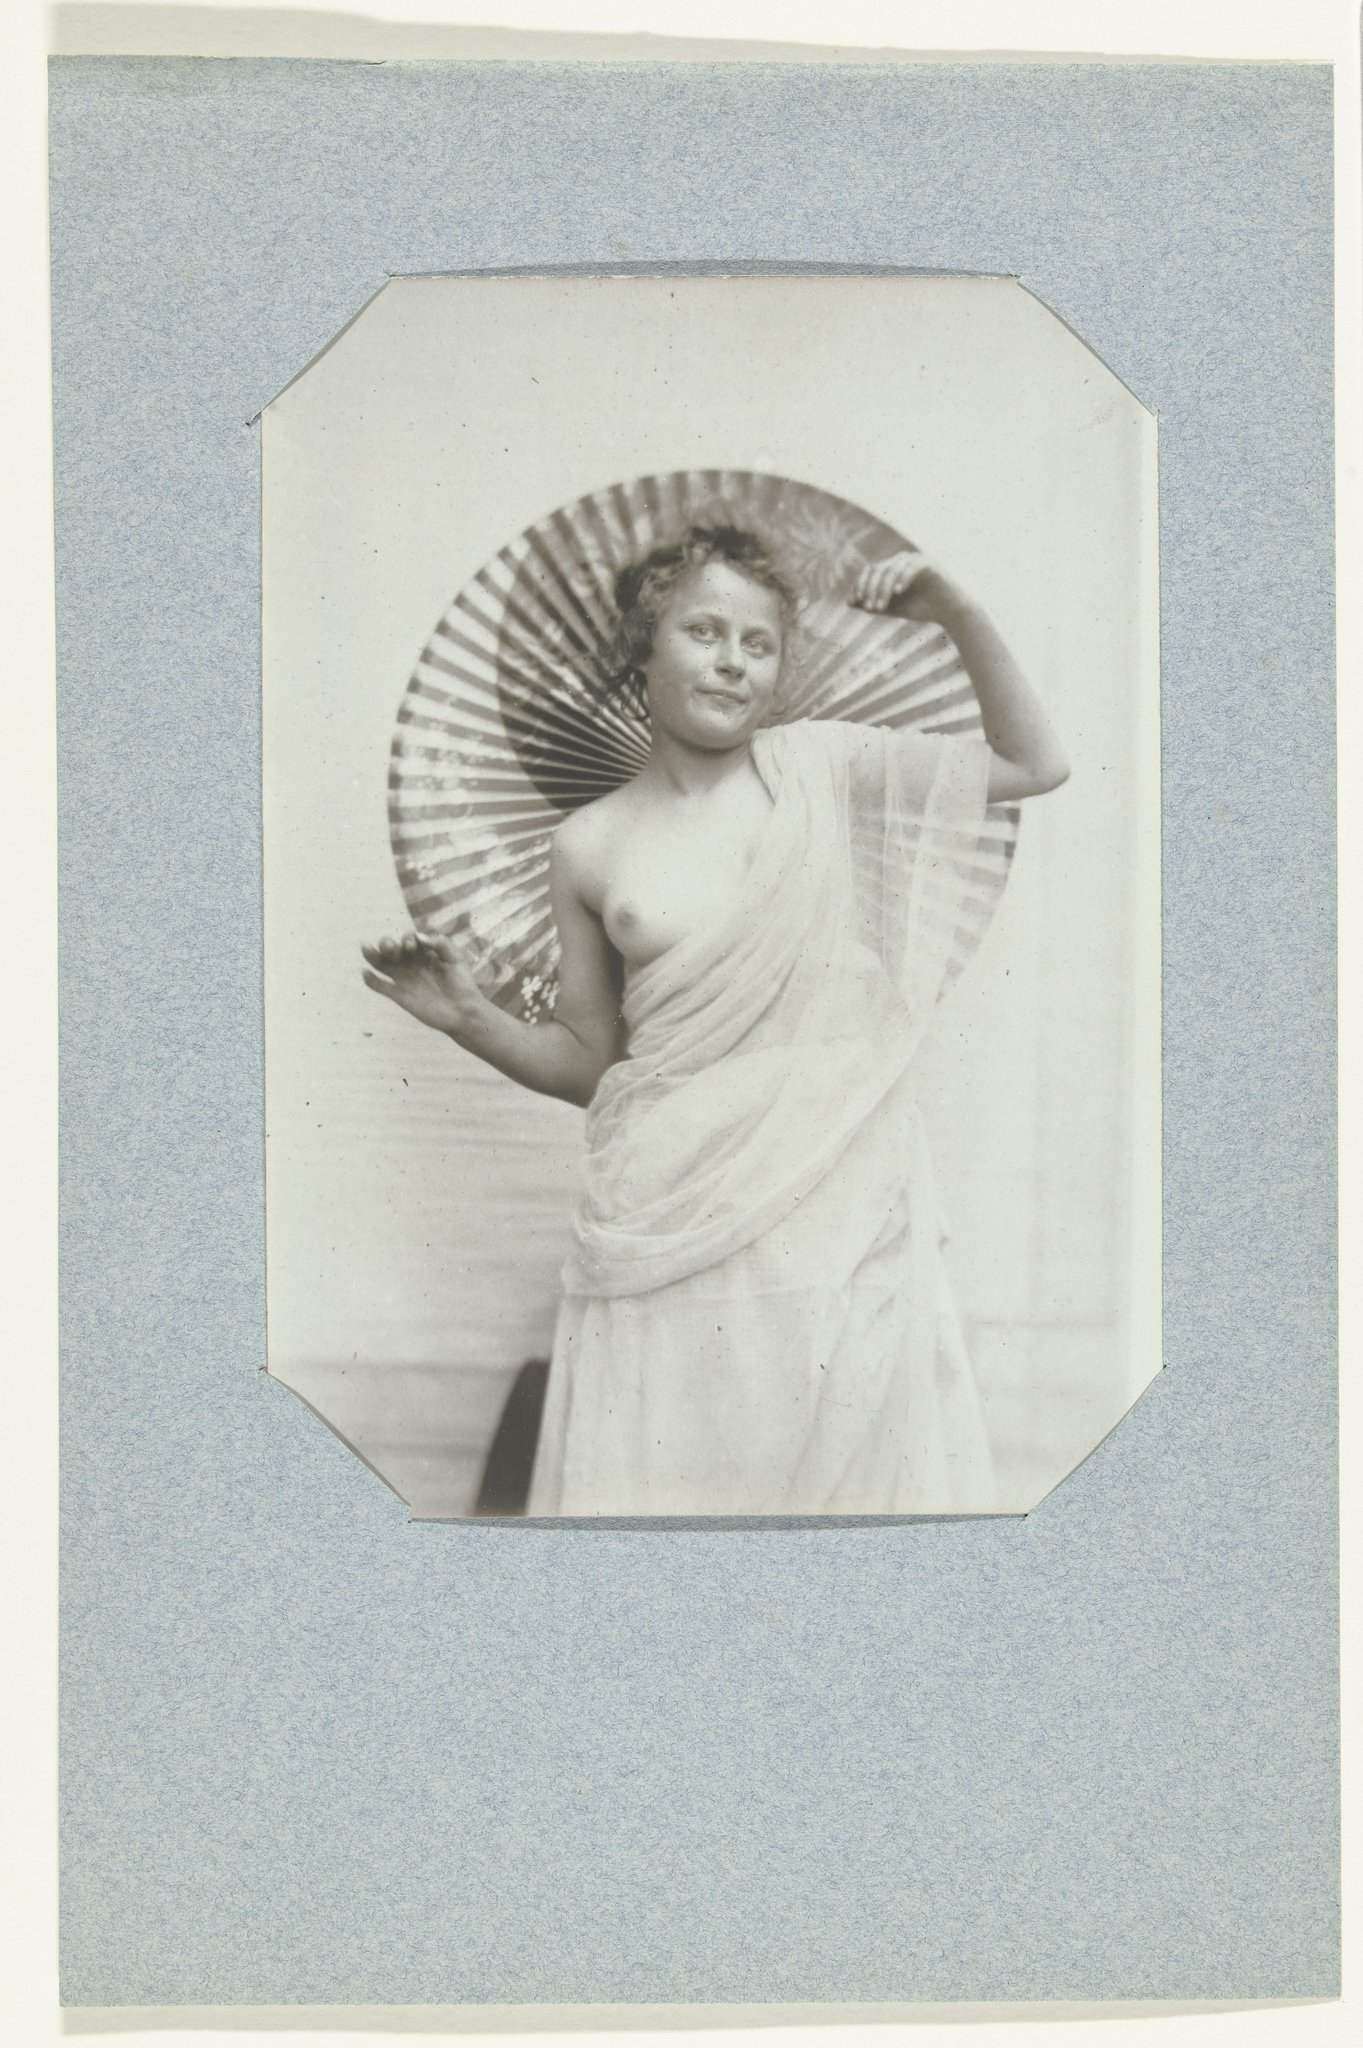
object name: photograph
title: Portret van een onbekende halfnaakte vrouw met parasol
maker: Anonymous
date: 1906-1910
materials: paper, cardboard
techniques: gelatin silver print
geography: france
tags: adult woman, historical persons not known by name - bb - woman, parasol, sunshade, france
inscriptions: inscription: ‘Octobre/ 1906/ Catalogue/ 971’